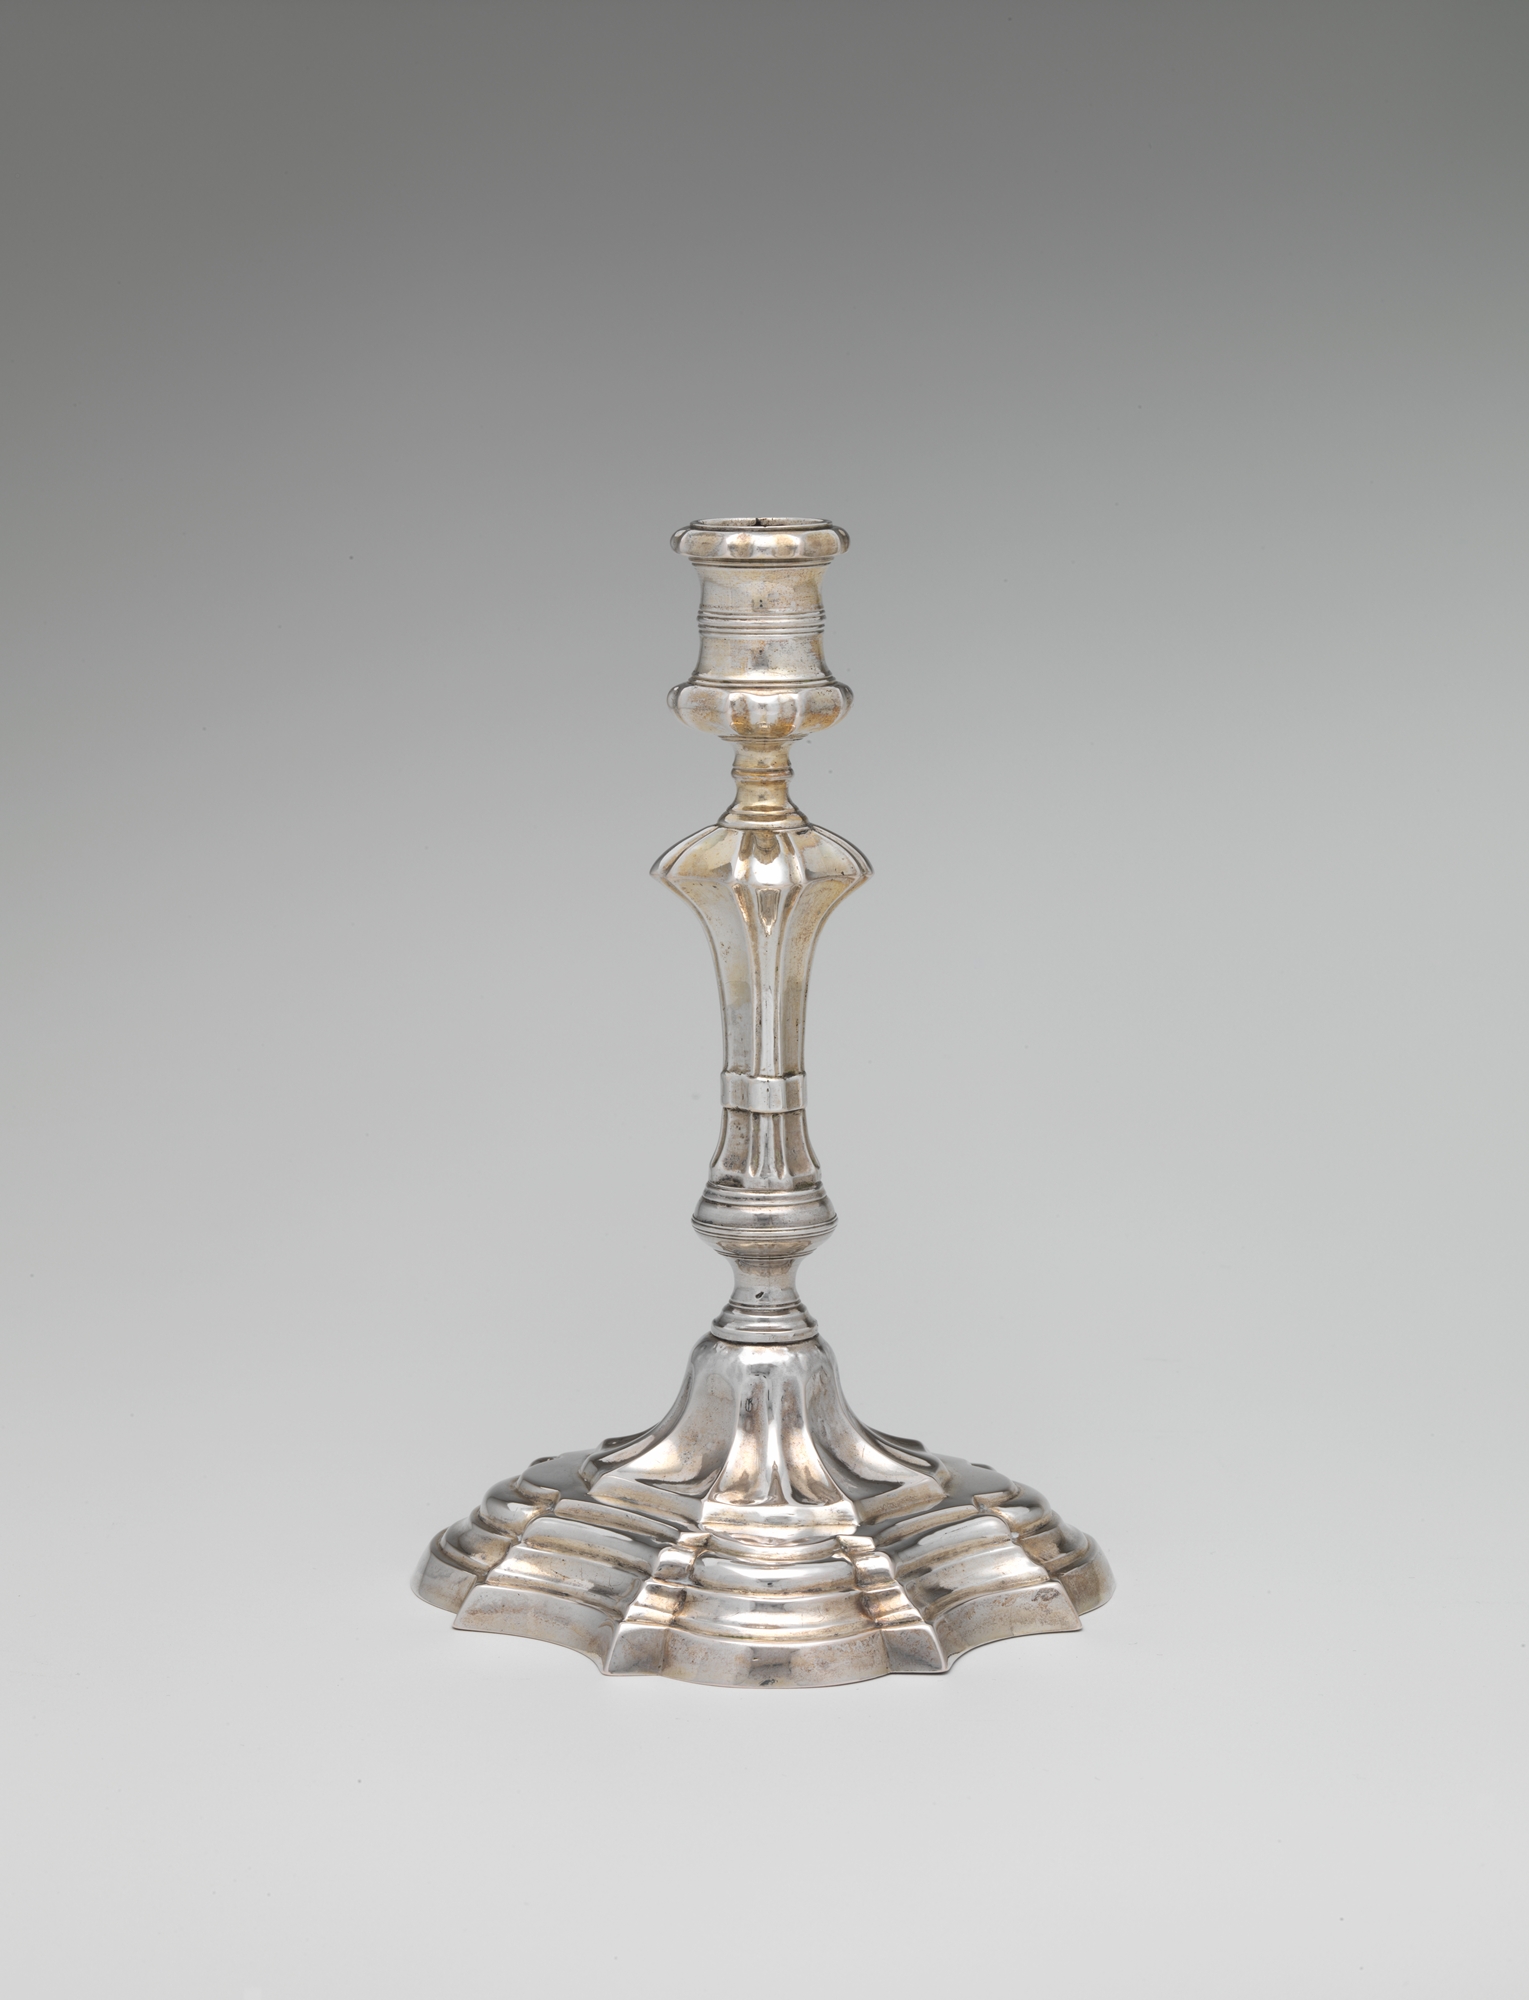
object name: candlestick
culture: american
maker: b. m.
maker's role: maker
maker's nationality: american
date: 1800-1900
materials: silver